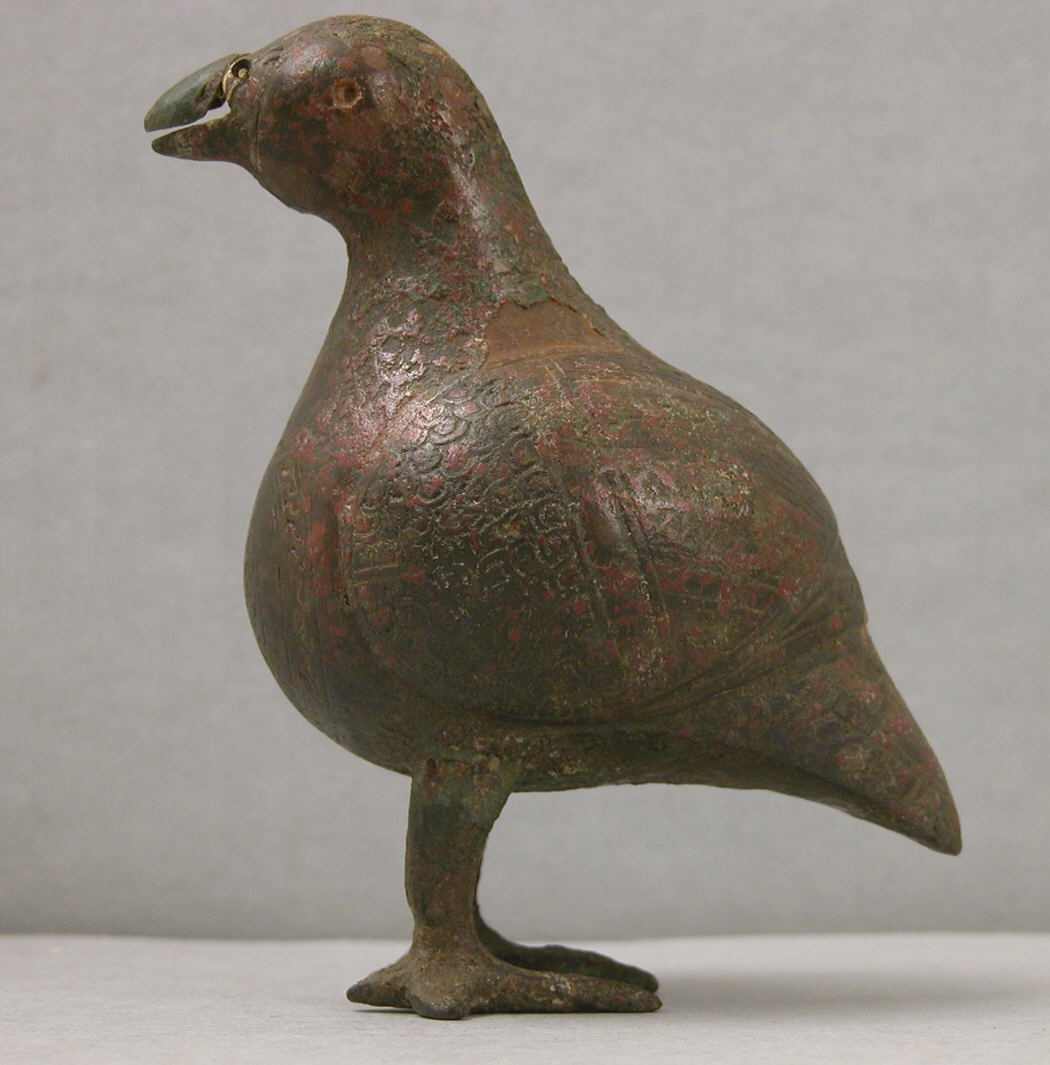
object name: figure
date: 1001-1200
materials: bronze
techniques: casting, engraving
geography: iran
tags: birds